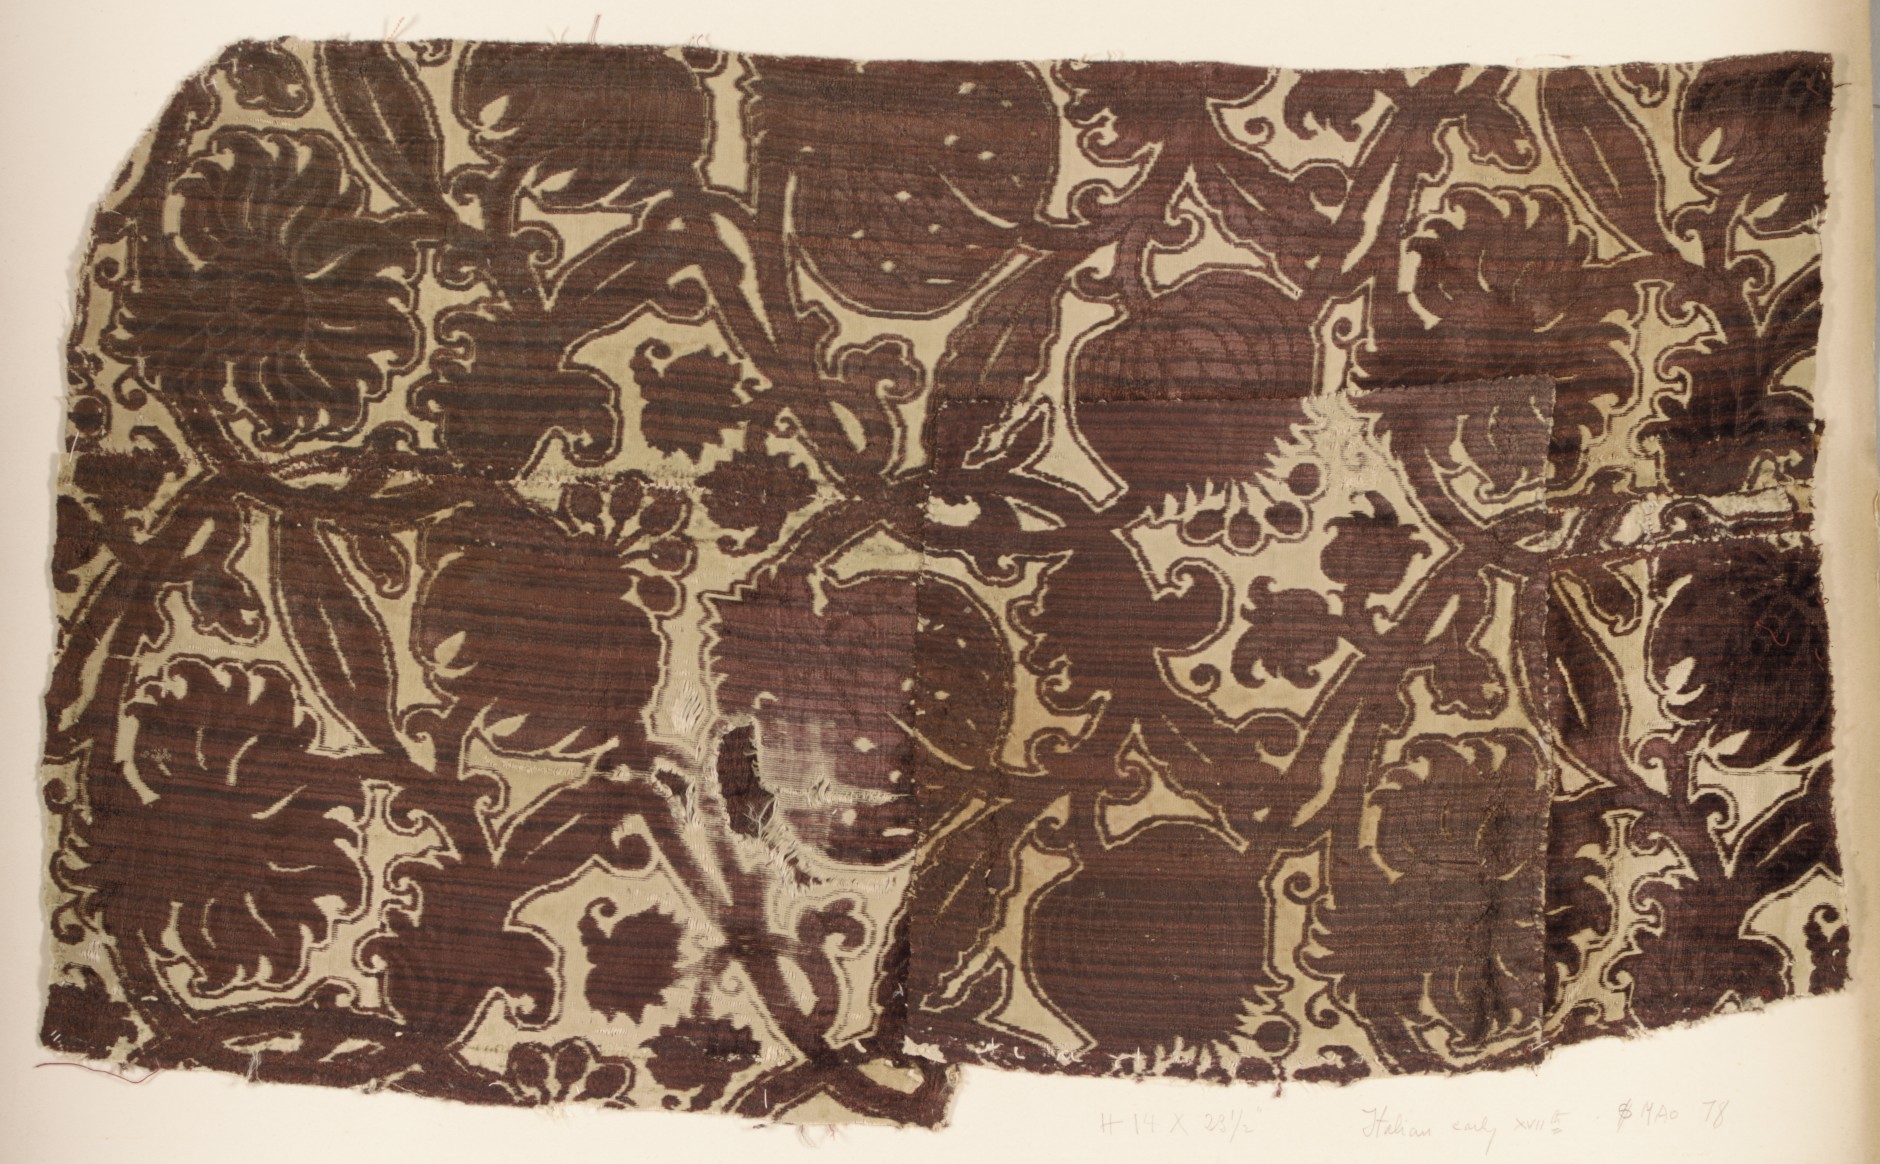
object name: fragment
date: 1601-1633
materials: silk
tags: flowers